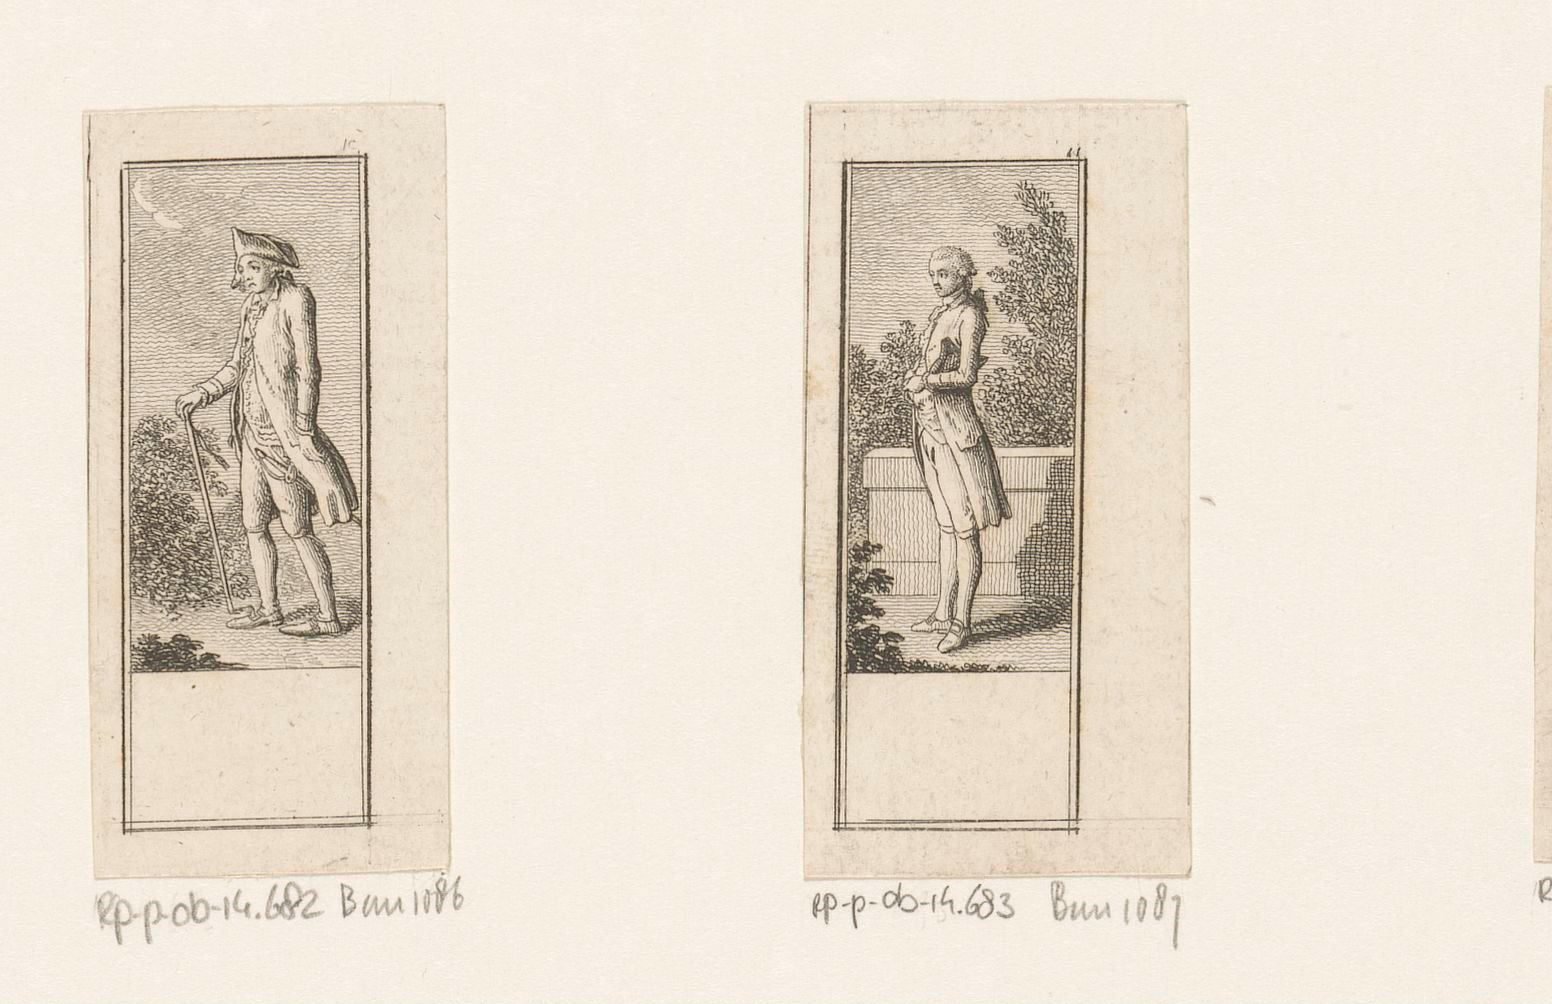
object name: print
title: Zorgeloosheid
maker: daniel nikolaus chodowiecki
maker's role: draughtsman, print maker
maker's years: 1726-1801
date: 1784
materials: paper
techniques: etching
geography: berlin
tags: good and bad behaviour, moral qualities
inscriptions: collector's mark: Lugt 2228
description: Latere staat gebruikt voor: Kleinen Taschen Calender auf das gemeine Jahr 1785 (...). Berlijn: S.n., 1784.